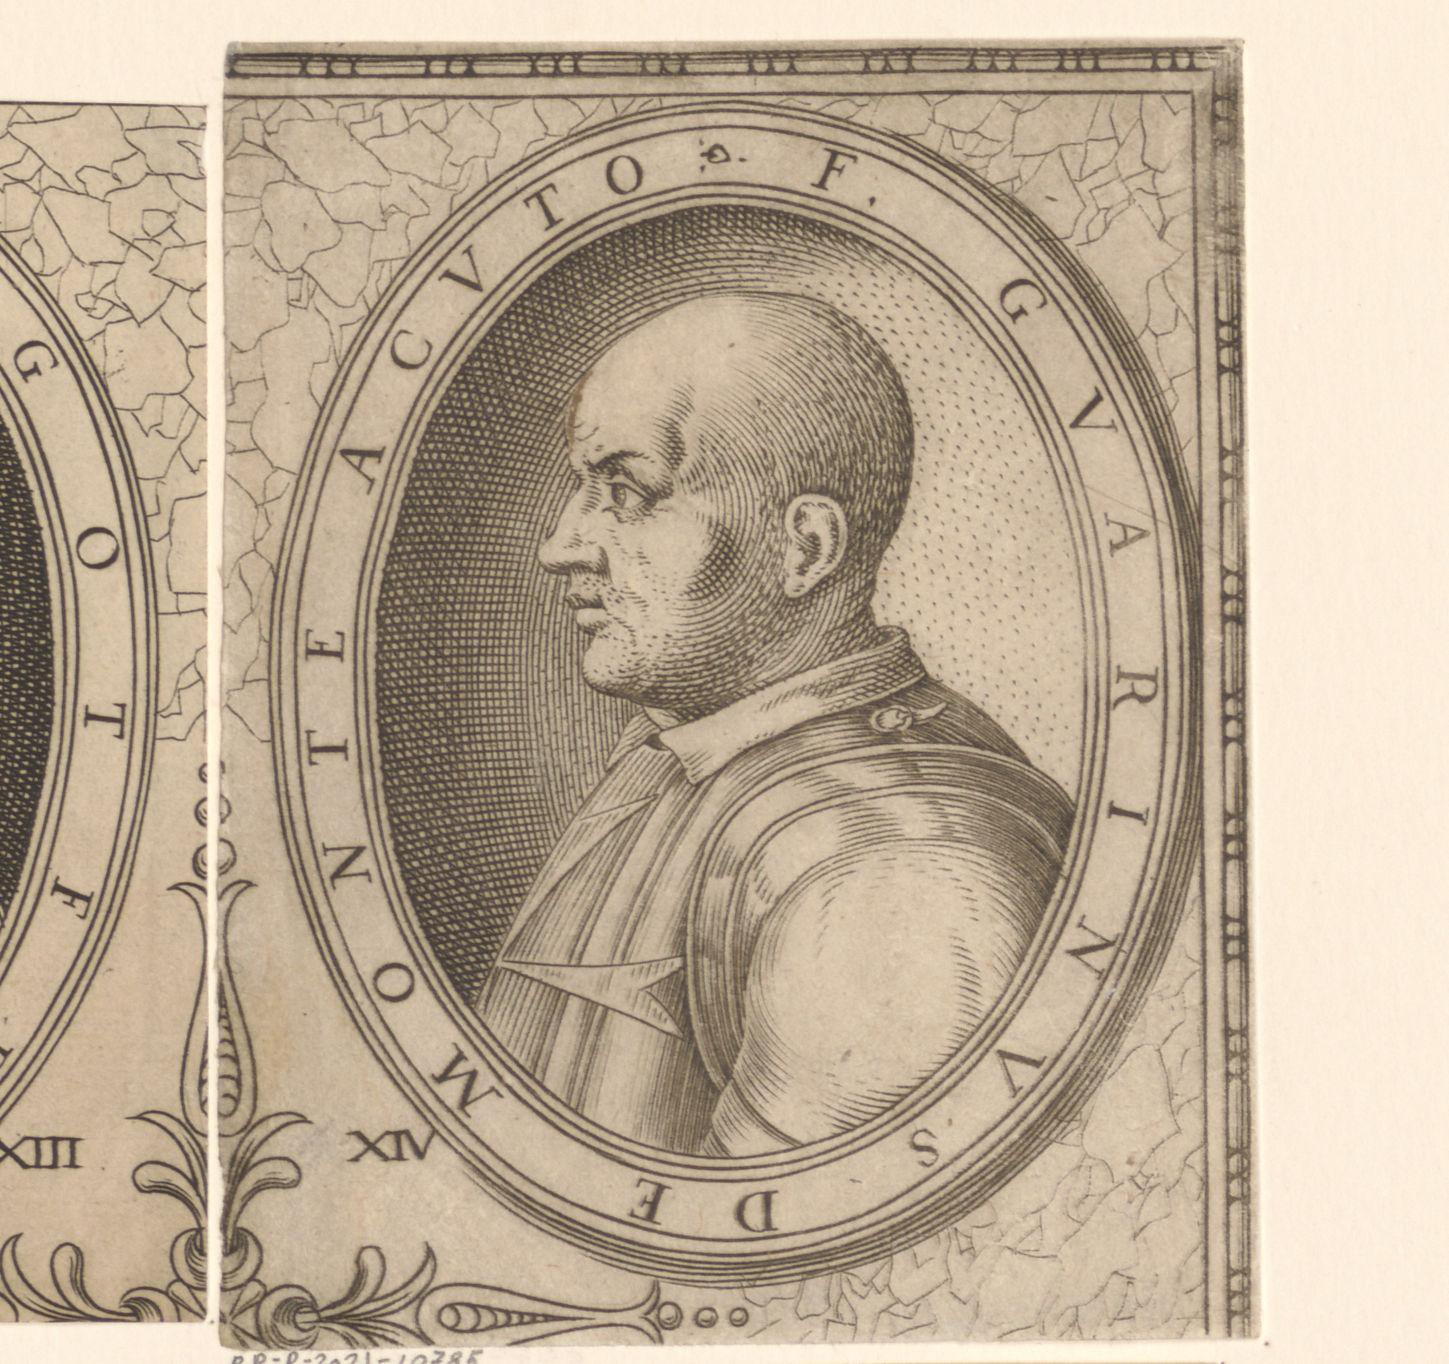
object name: print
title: Portret van Guérin de Montaigu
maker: philippe thomassin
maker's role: print maker, publisher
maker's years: 1562-1622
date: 1588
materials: paper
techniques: engraving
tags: historical persons, military orders, e.g.: knights templars, knights of malta, teutonic knights ~ roman catholic church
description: Deze prent maakt deel uit van een grotere prent met vier portretten die later is verknipt. Prent waarschijnlijk uit: Veltroni, Tolomeo. Statuta hospitalis Hierusalem. [Rome: s.n., 1588].